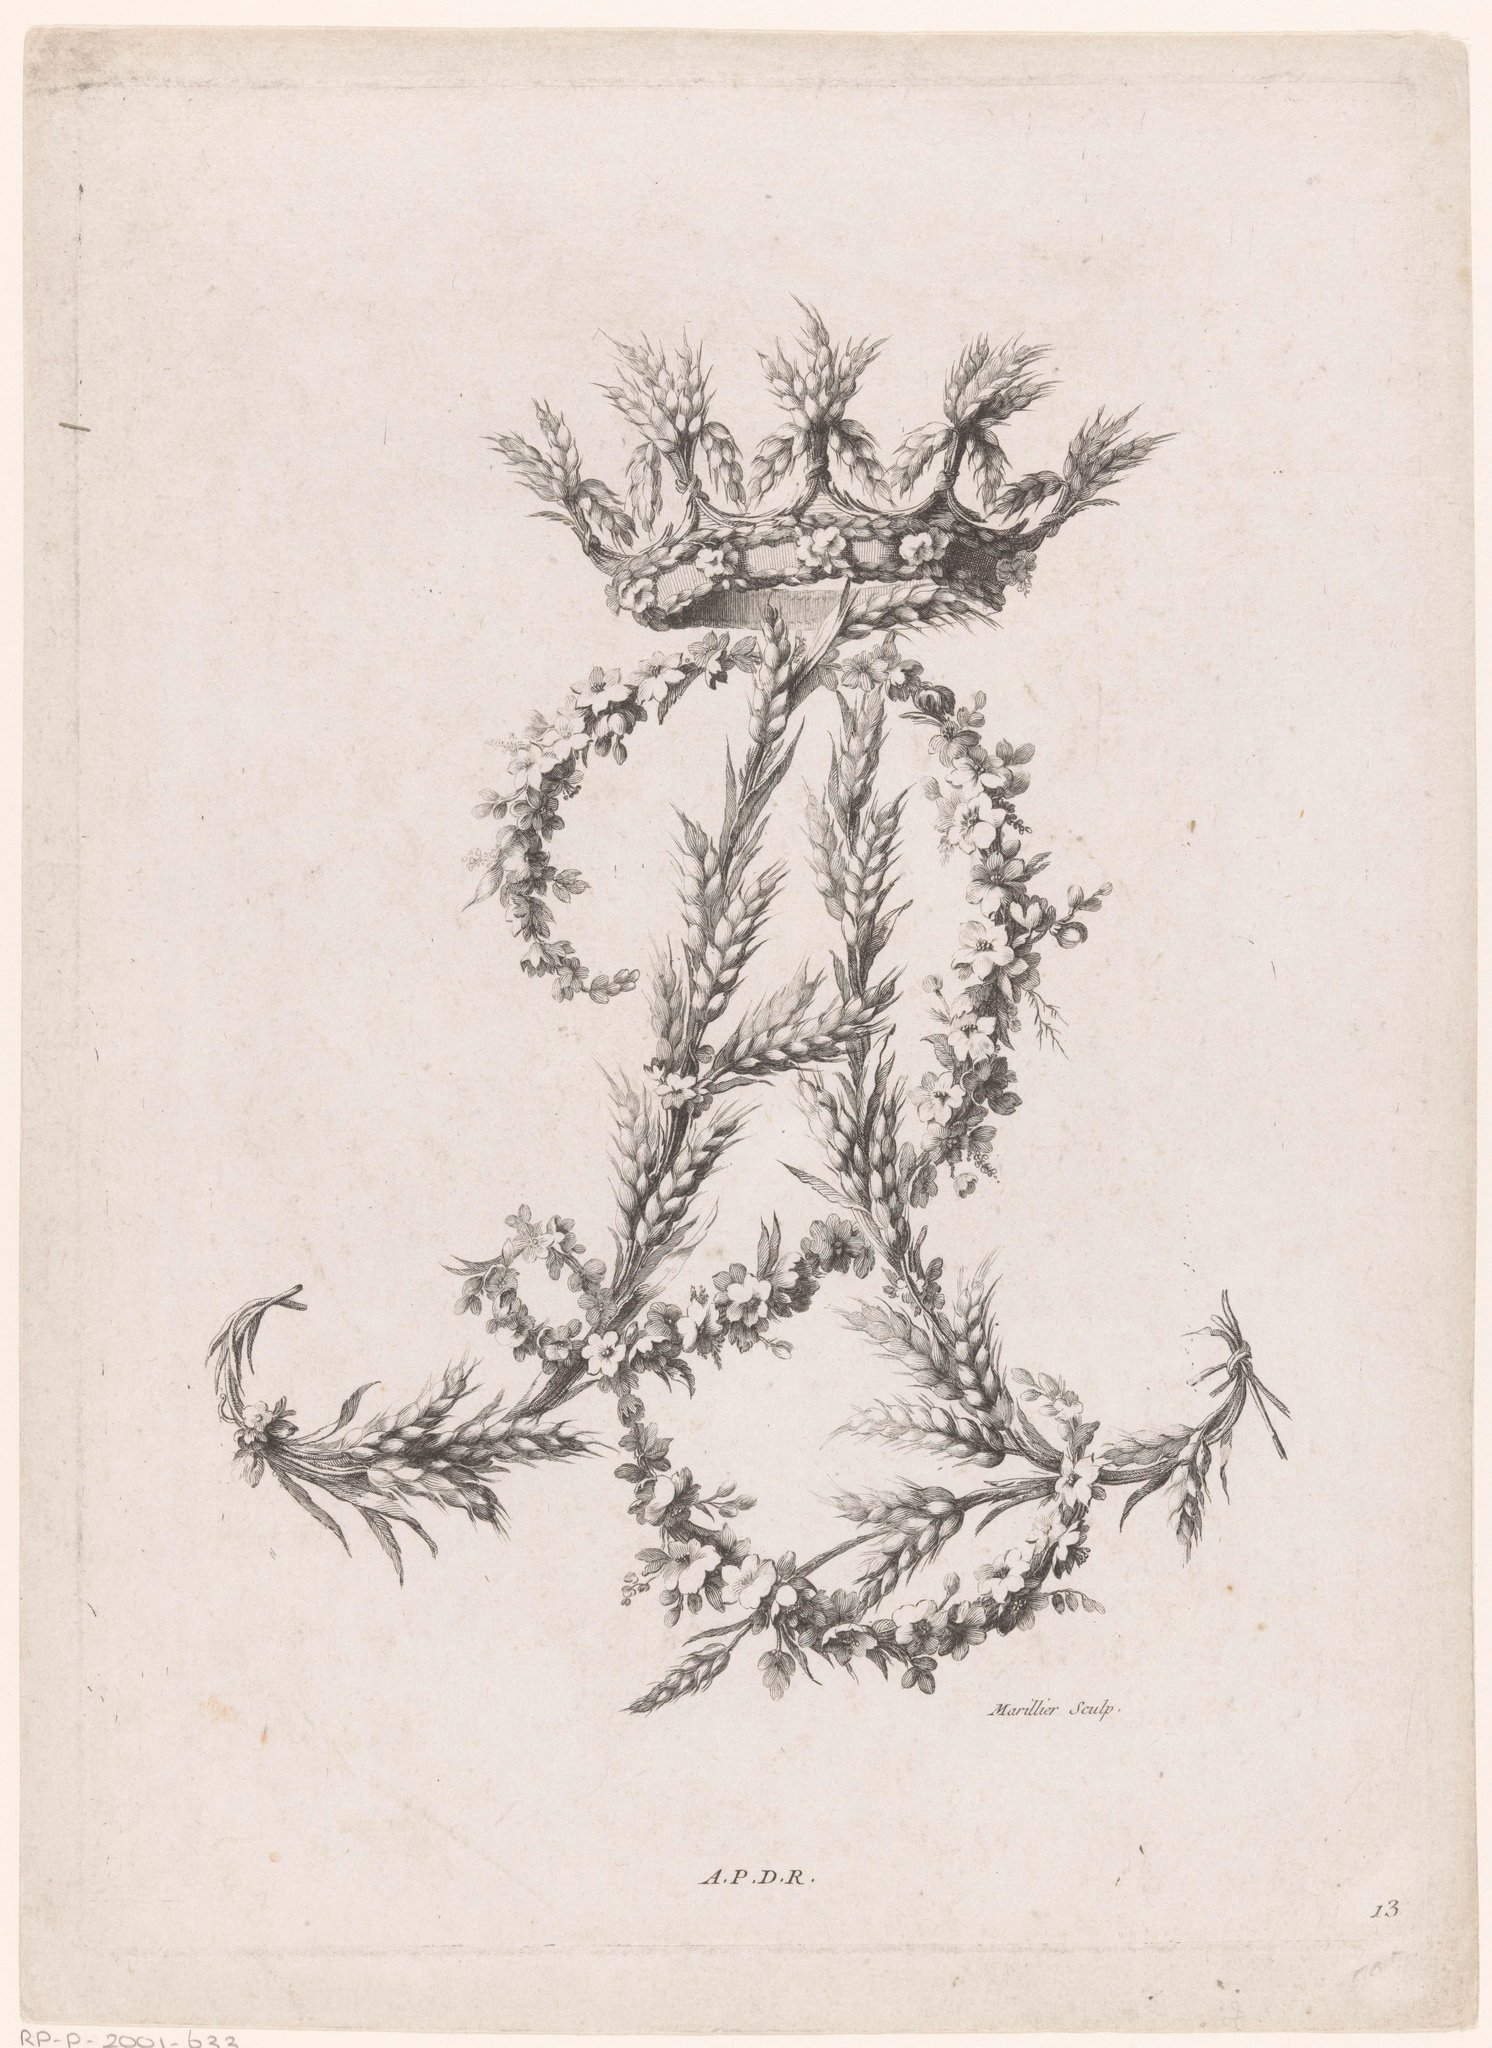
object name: print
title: IIme Recueil de Chiffres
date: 1755-1768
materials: paper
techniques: etching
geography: paris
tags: letters, alphabet, script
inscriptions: collector's mark: Lugt 2760, collector's mark: Lugt 2228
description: Prent is onderdeel van een serie van zes. Deze serie vormt samen met Premier Recueil De Chiffres (zeven prenten) een serie van dertien. Dit is prent 13 van 13.